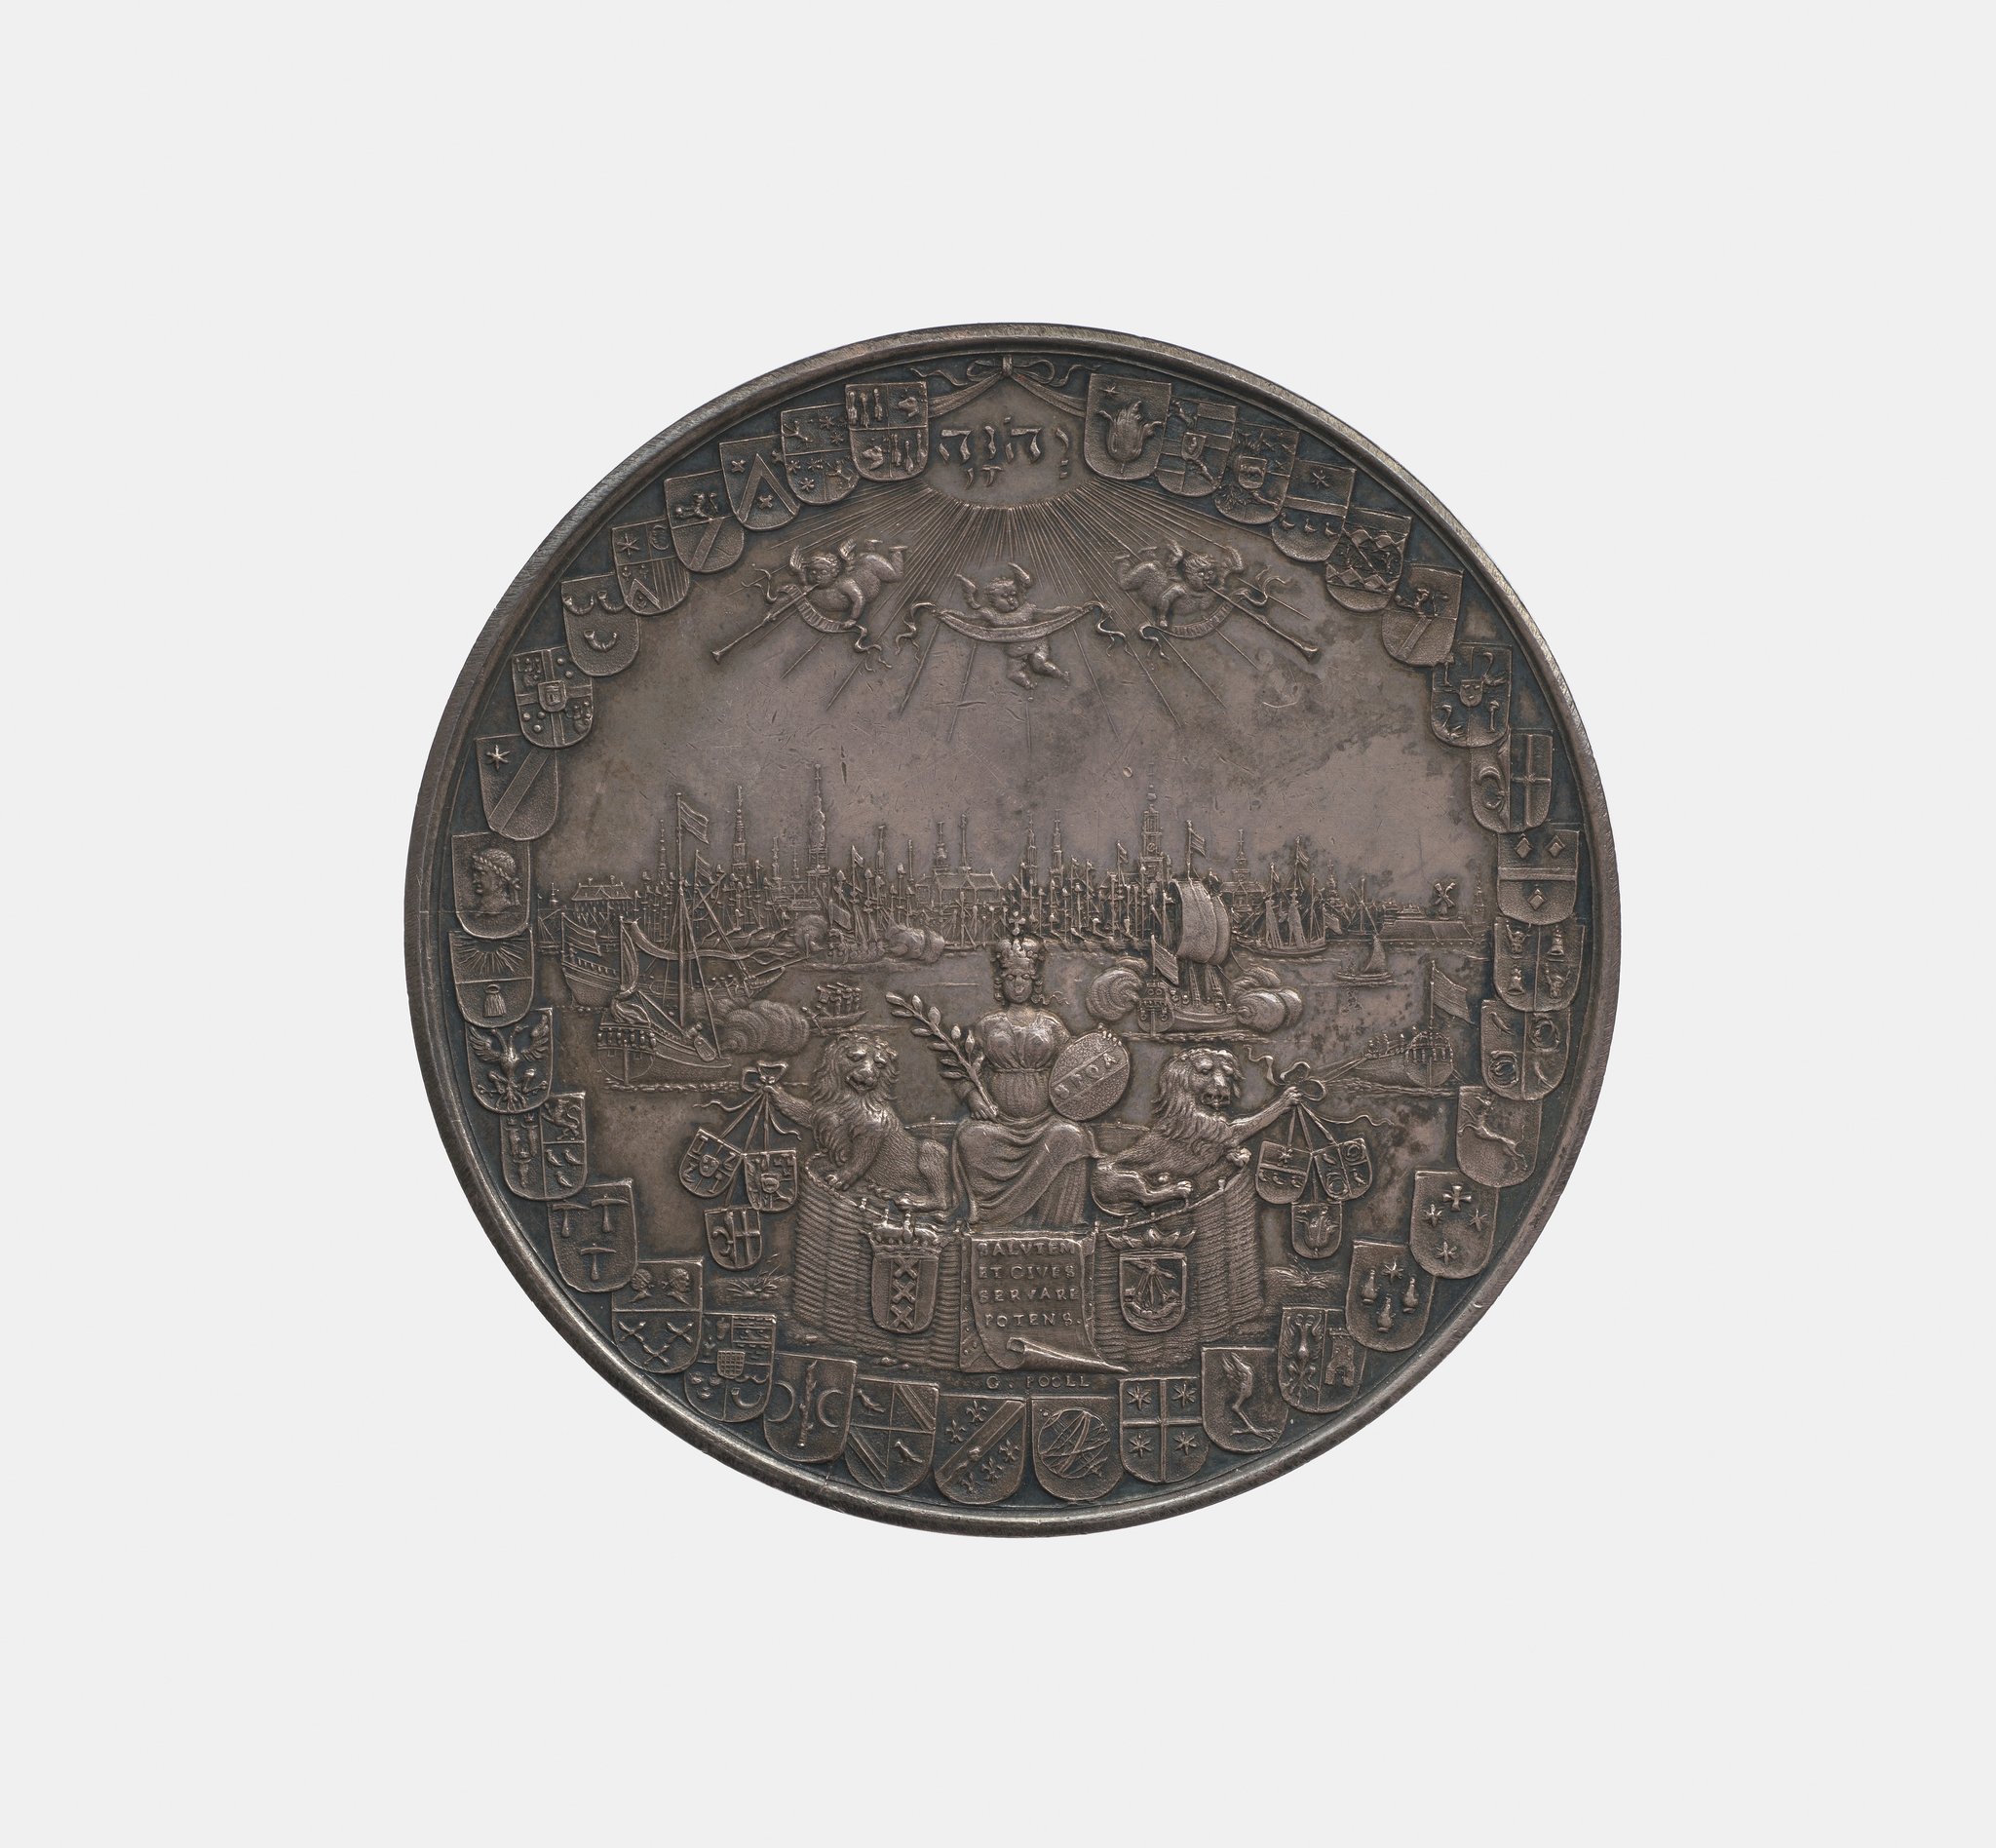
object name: medal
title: Amsterdam Town Hall "Stadhuis"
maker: jurriaen i pool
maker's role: artist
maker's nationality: dutch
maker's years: 1618-1699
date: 1655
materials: silver